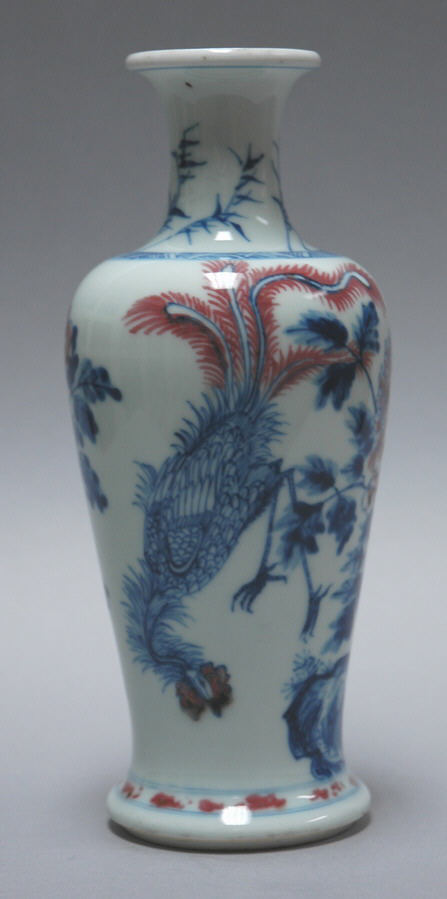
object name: vase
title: Vase with Phoenix and Peonies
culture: chinese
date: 1667-1700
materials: cobalt, copper, glaze, porcelain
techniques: painting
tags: phoenix,peonies